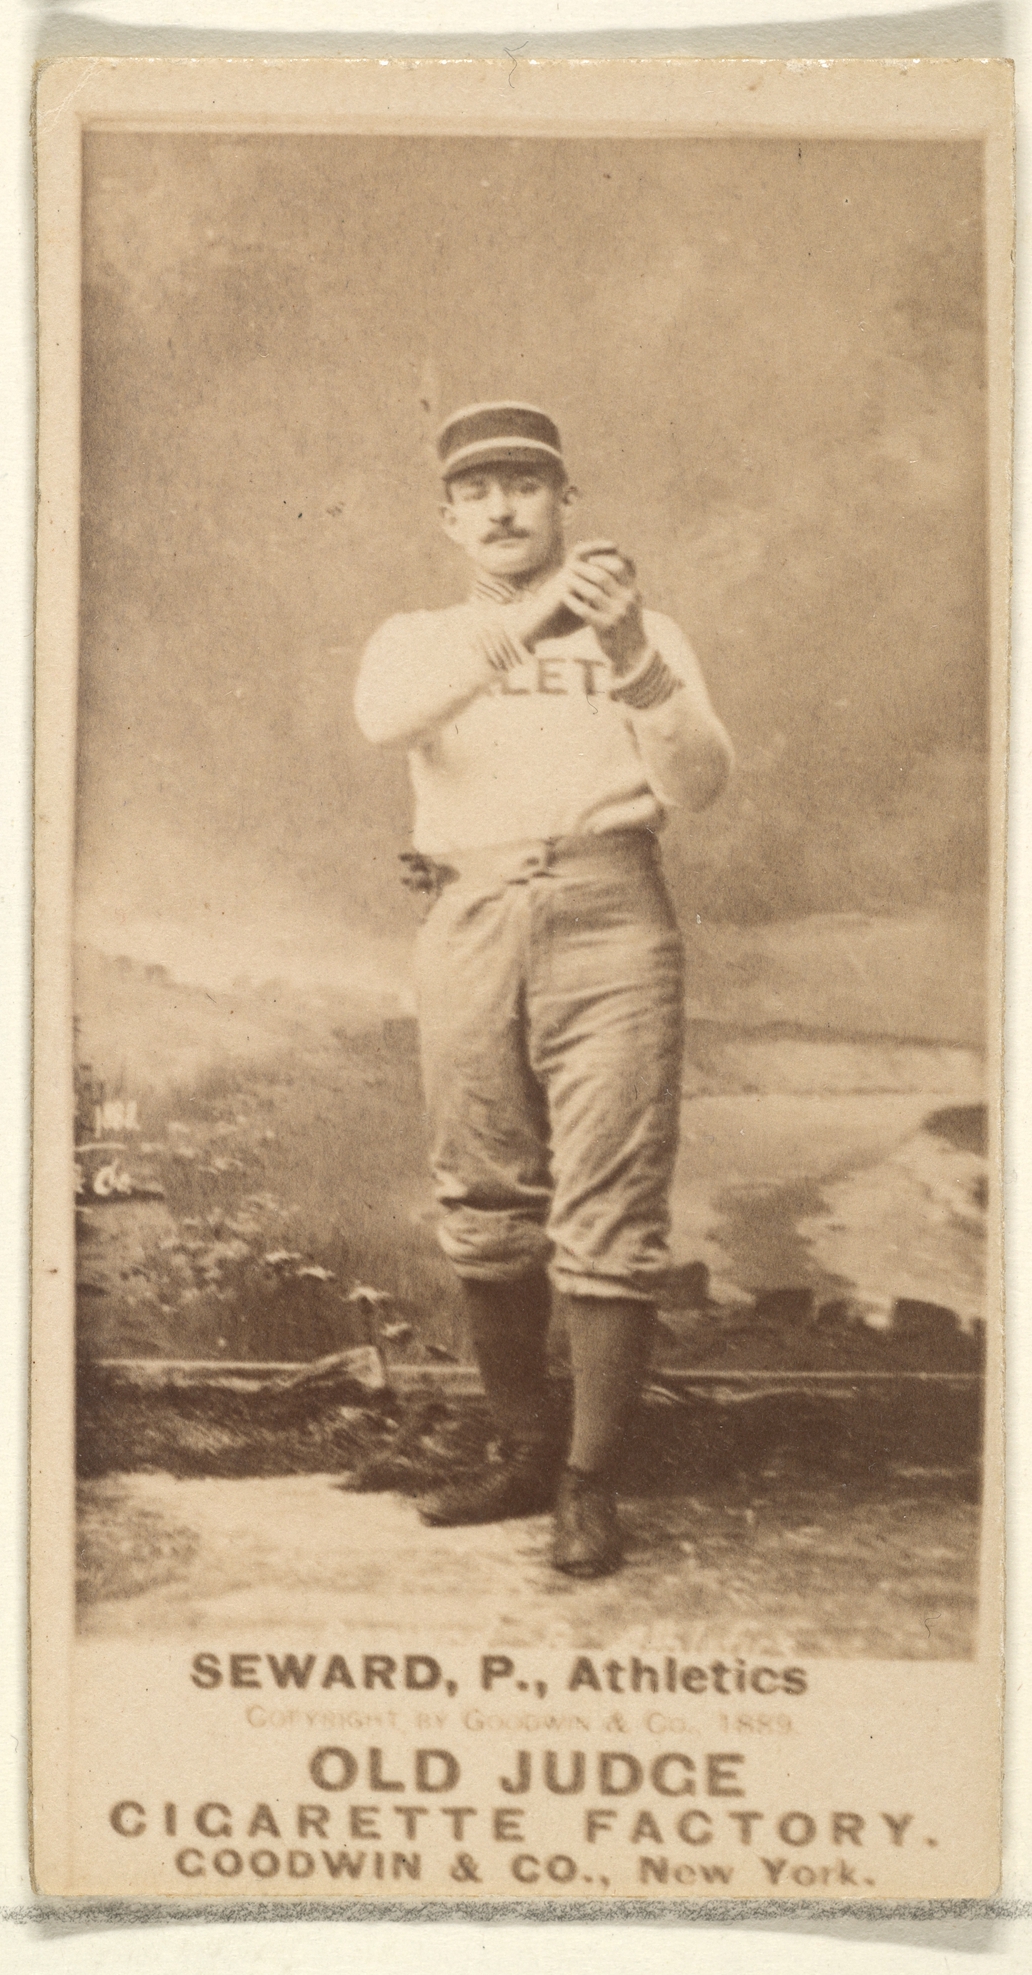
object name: baseball card, photograph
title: Seward, Pitcher, Philadelphia Athletics, from the Old Judge series (N172) for Old Judge Cigarettes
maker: goodwin & company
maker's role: publisher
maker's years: 1850-1950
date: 1887-1890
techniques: albumen silver print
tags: men,portraits,baseball,athletes